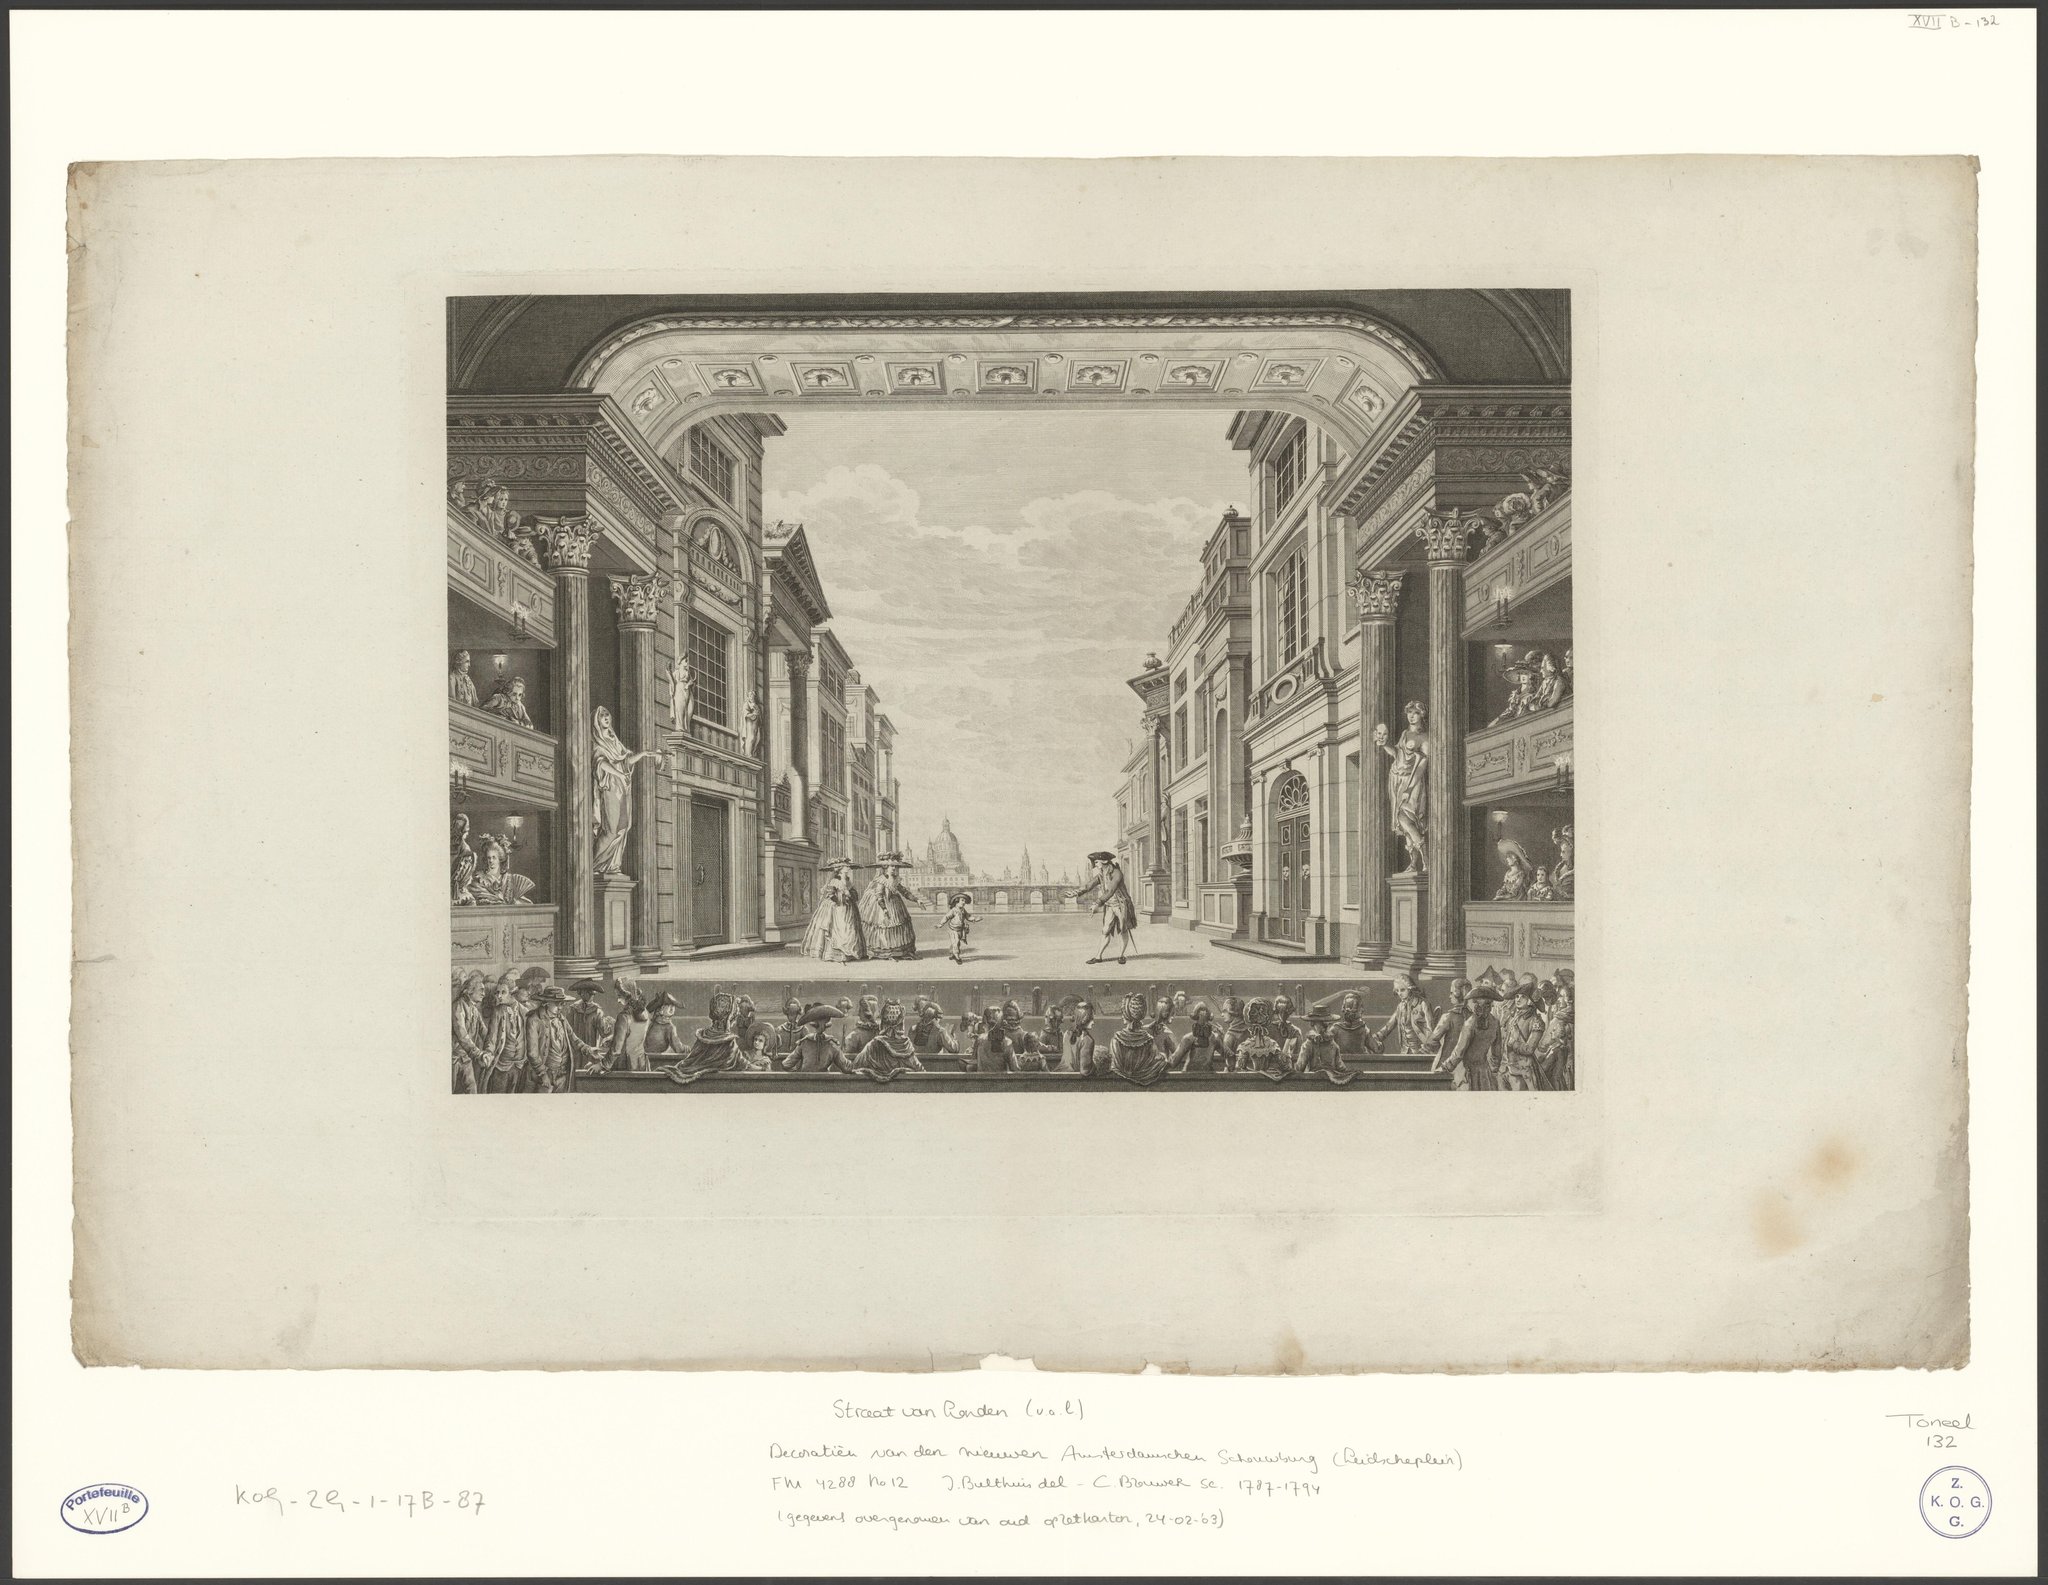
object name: print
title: Toneeldecors van de nieuwe Amsterdamse Schouwburg, 1787-1794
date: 1788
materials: paper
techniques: engraving, etching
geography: amsterdam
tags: theatre, theatrical performance, stage design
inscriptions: stamp, collector's mark: Lugt 1641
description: Toneelvoorstelling in de nieuwe Amsterdamse Schouwburg met het coulissendecor De Straat van Londen, met scène uit Beverly. Het decor gedrukt van een aparte plaat binnen een vernieuwde passe-partout met de zaal, zijloges, pilaren met standbeelden en de façade van het toneel. Onderdeel van de serie van veertien toneeldecors van de nieuwe Amsterdamse Schouwburg, 1787-1794. Onderwerpsrubrieken binnen de Atlas Zeden en Gewoonten: Schoone kunsten, Tooneel, Decors voor de Schouwburg.